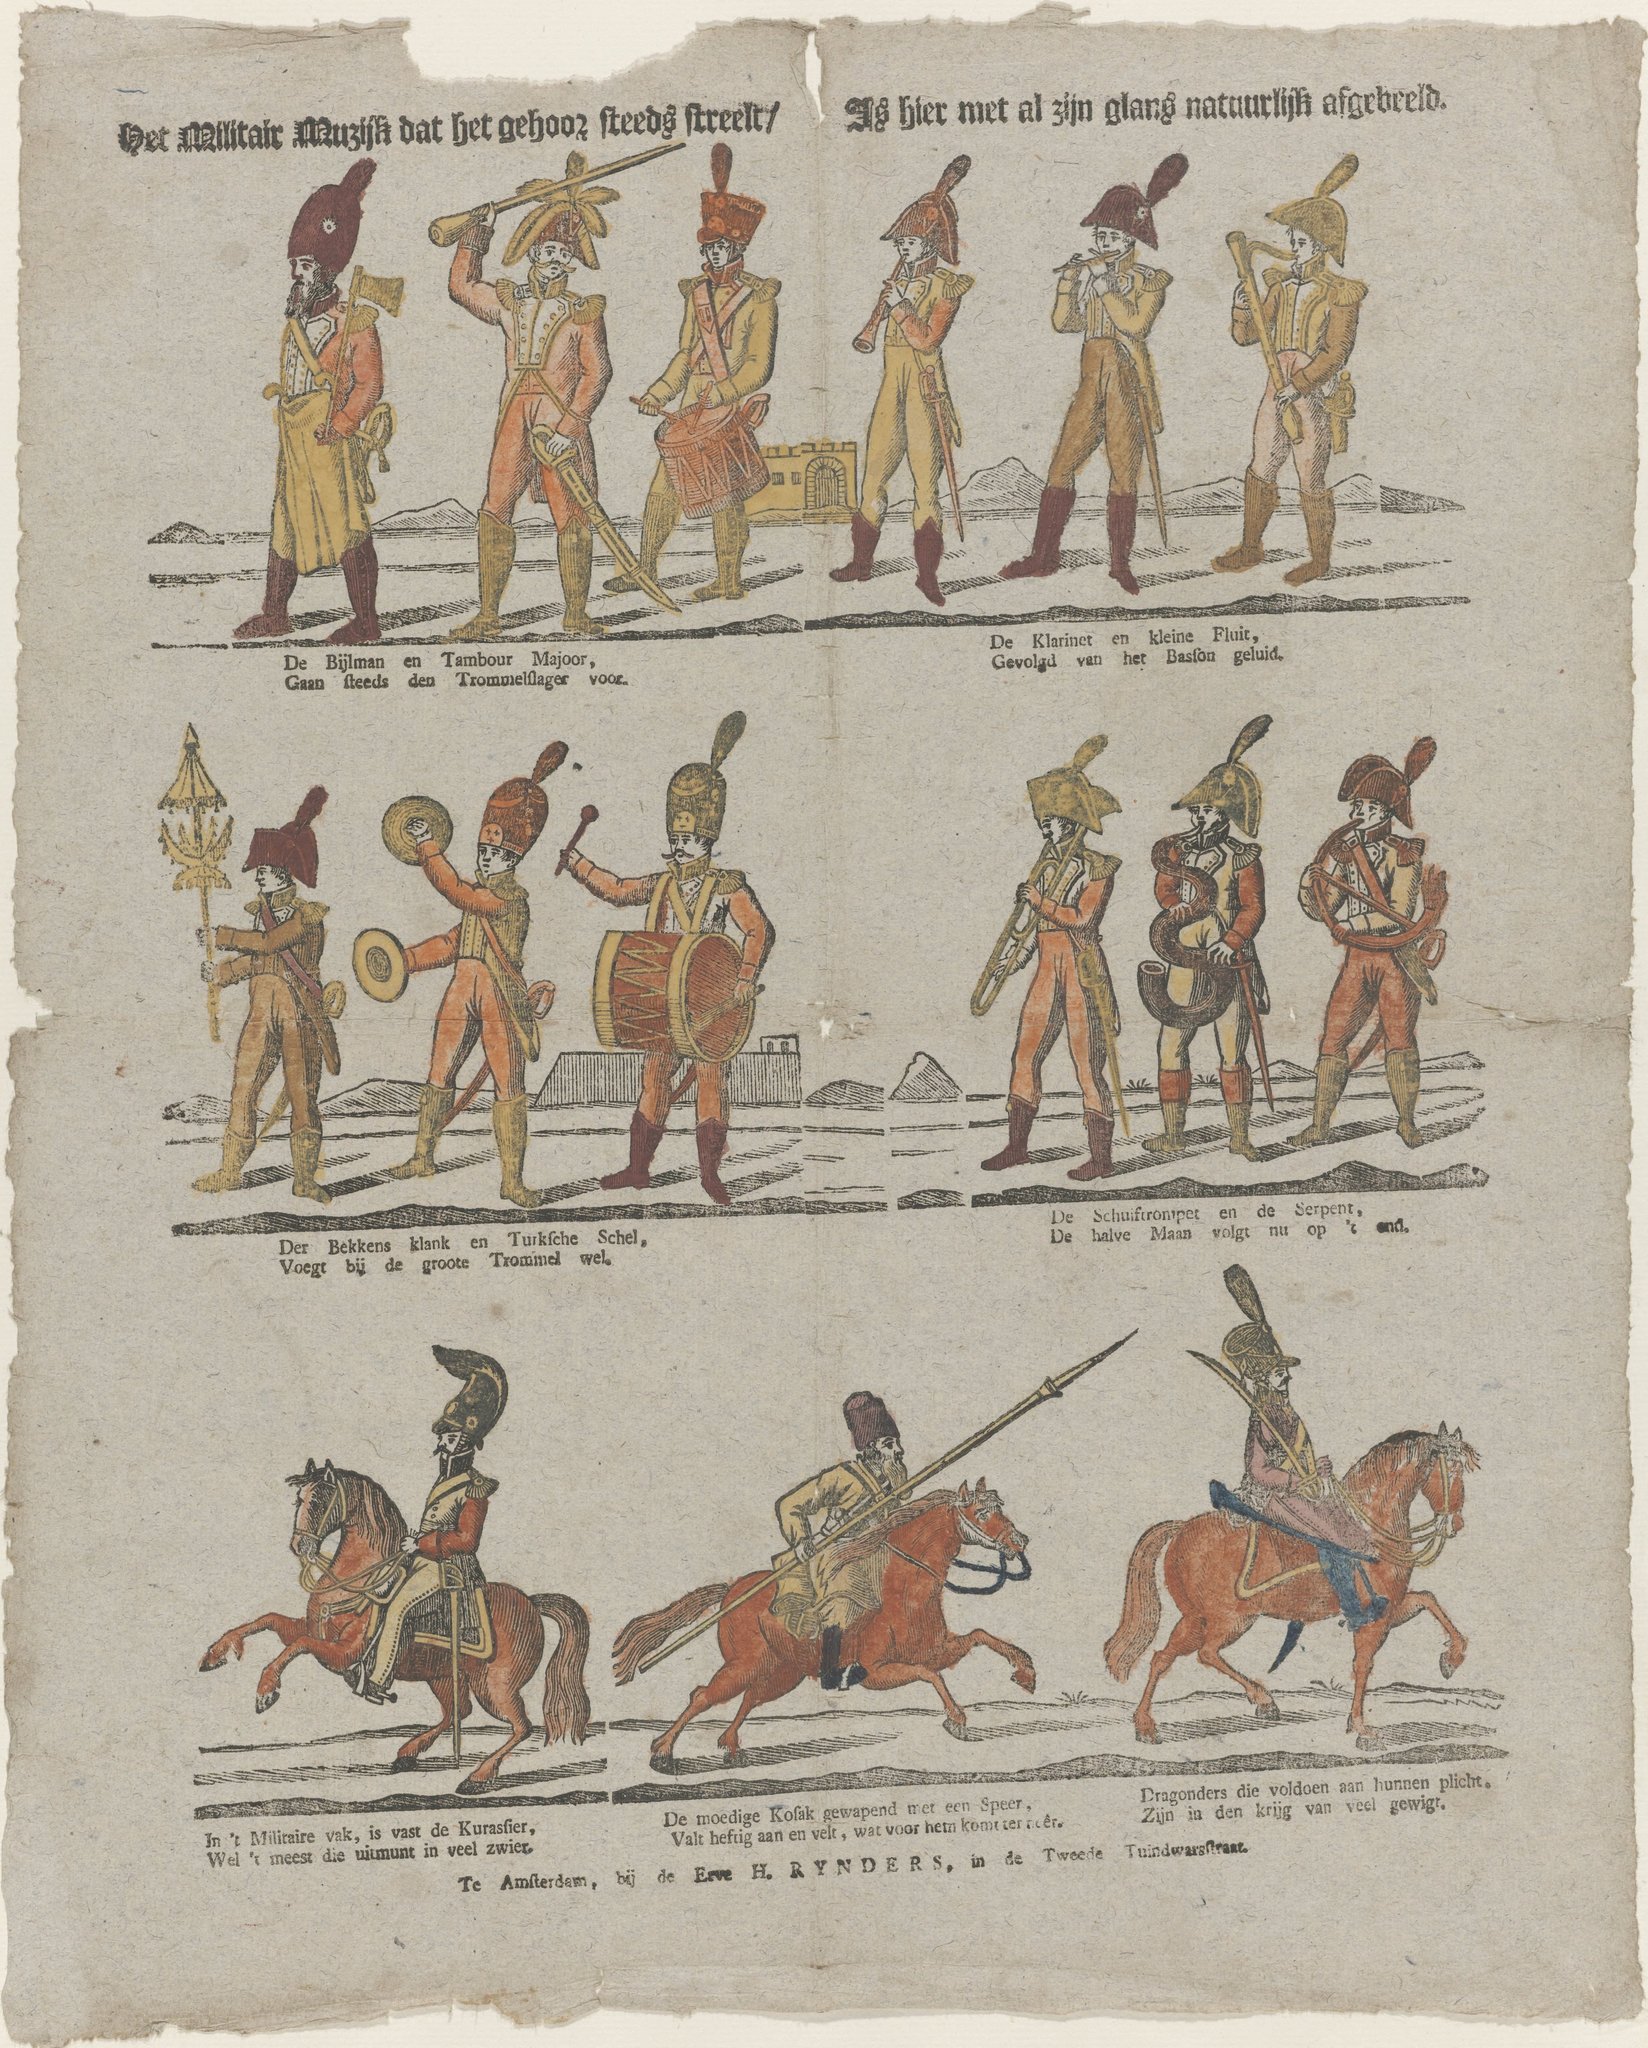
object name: popular print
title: Het militair muzijk dat het gehoor steeds streelt / Is hier met al zijn glans natuurlijk afgebeeld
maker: Anonymous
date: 1831-1854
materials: paper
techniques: colour, letterpress printing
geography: amsterdam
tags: military band, warfare; military affairs (+ cavalry, horsemen), the soldier; the soldier's life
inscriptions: collector's mark: Lugt 2760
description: Blad met 3 horizontale rijen met voorstellingen van militaire muzikanten en militairen te paard. Onder elke rij een vierregelig vers in twee kolommen.